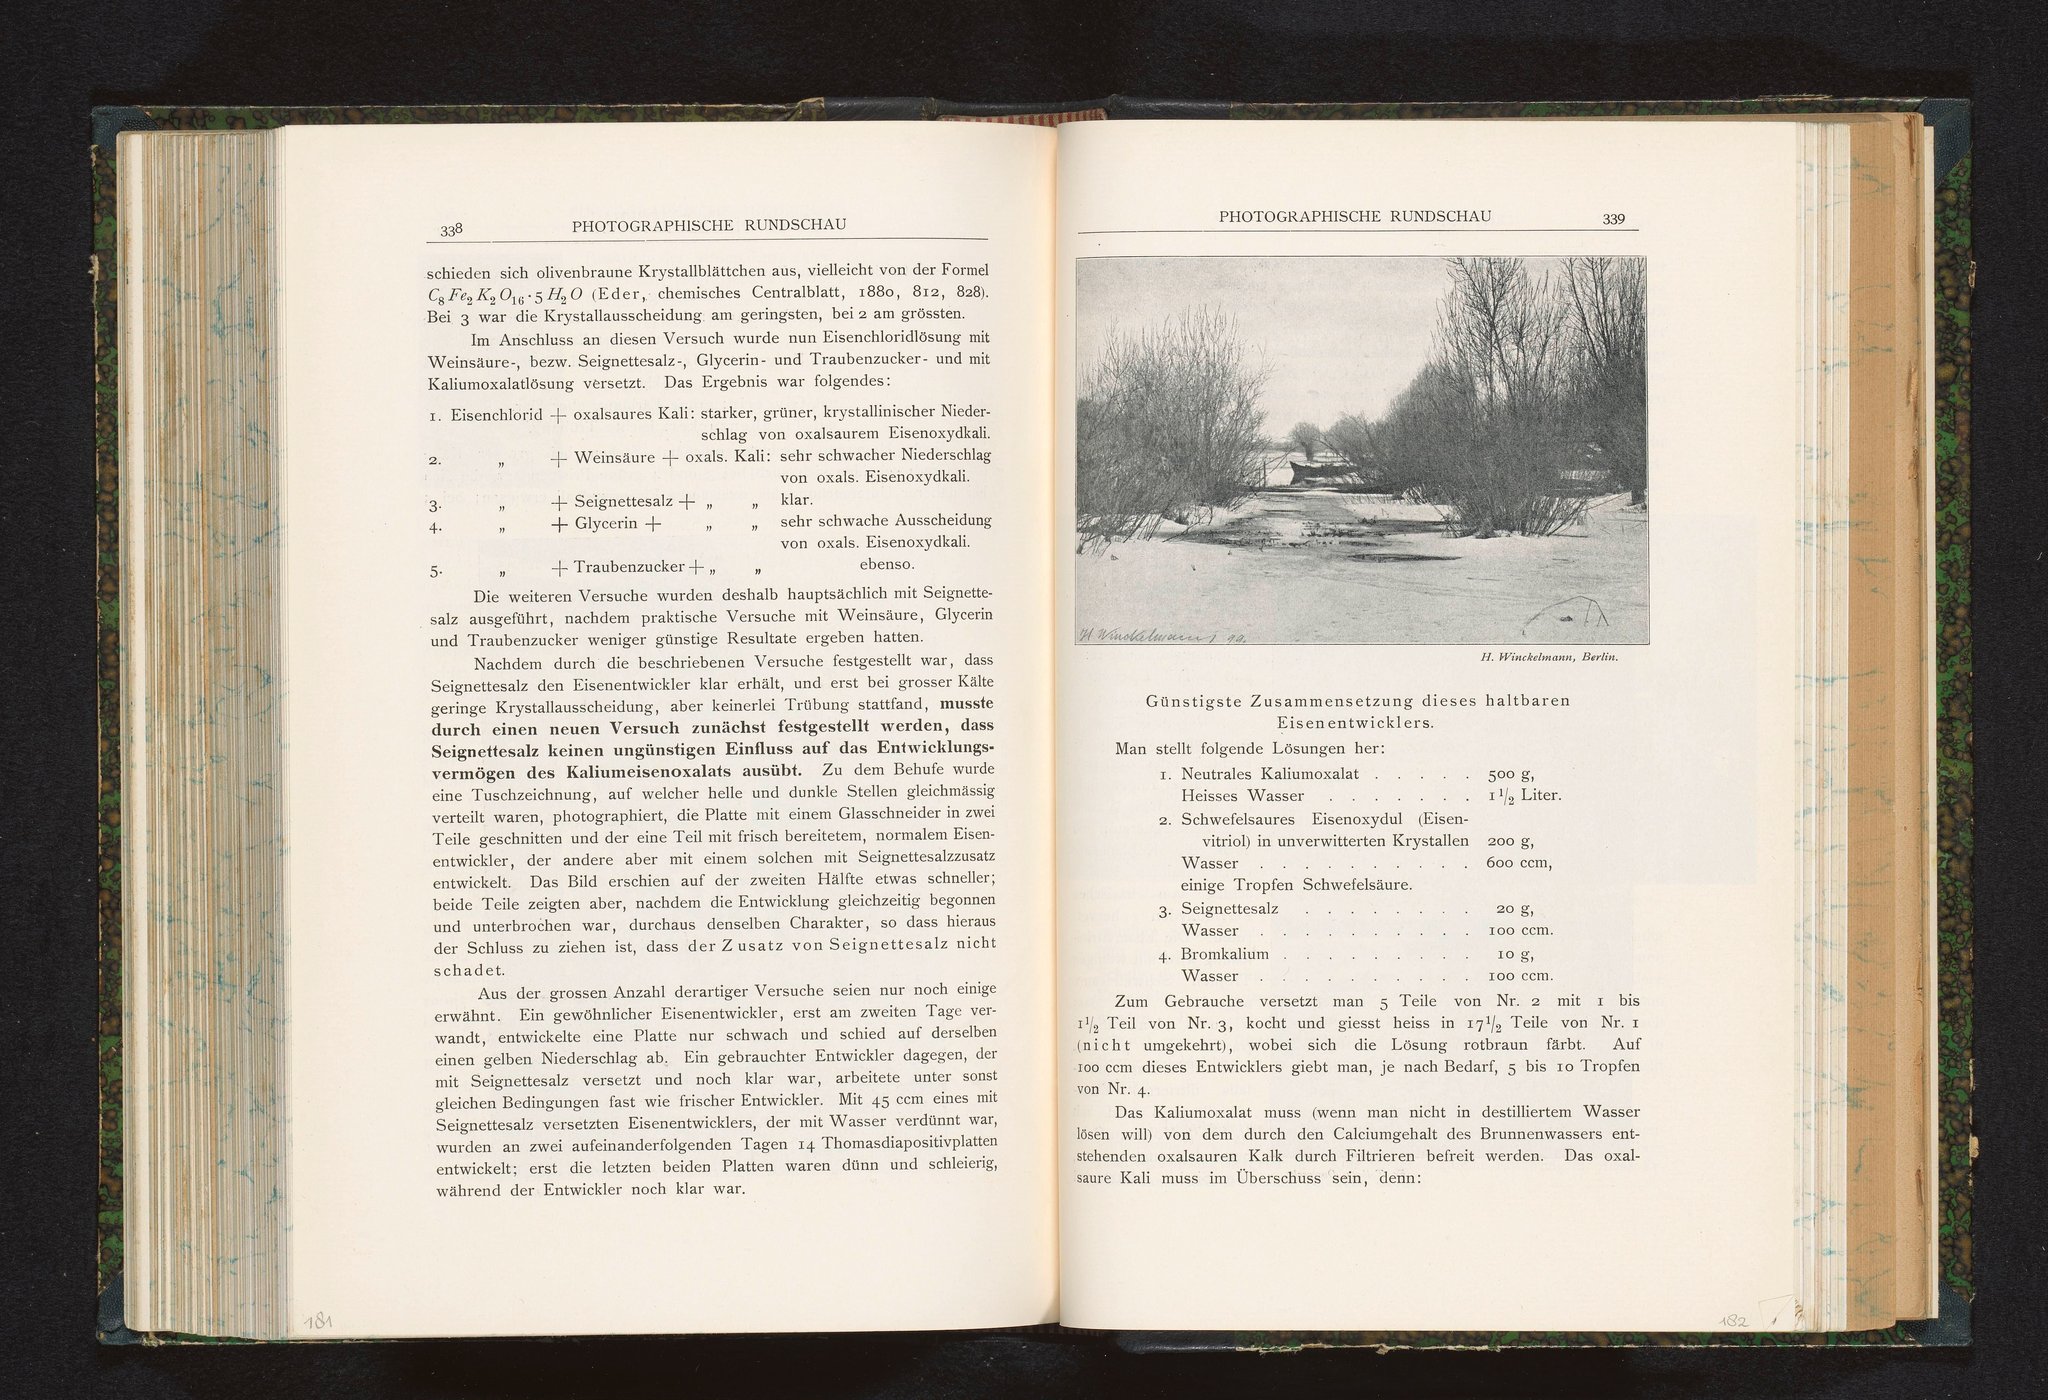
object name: page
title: Winters landschap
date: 1899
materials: paper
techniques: autotype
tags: landscapes, snow